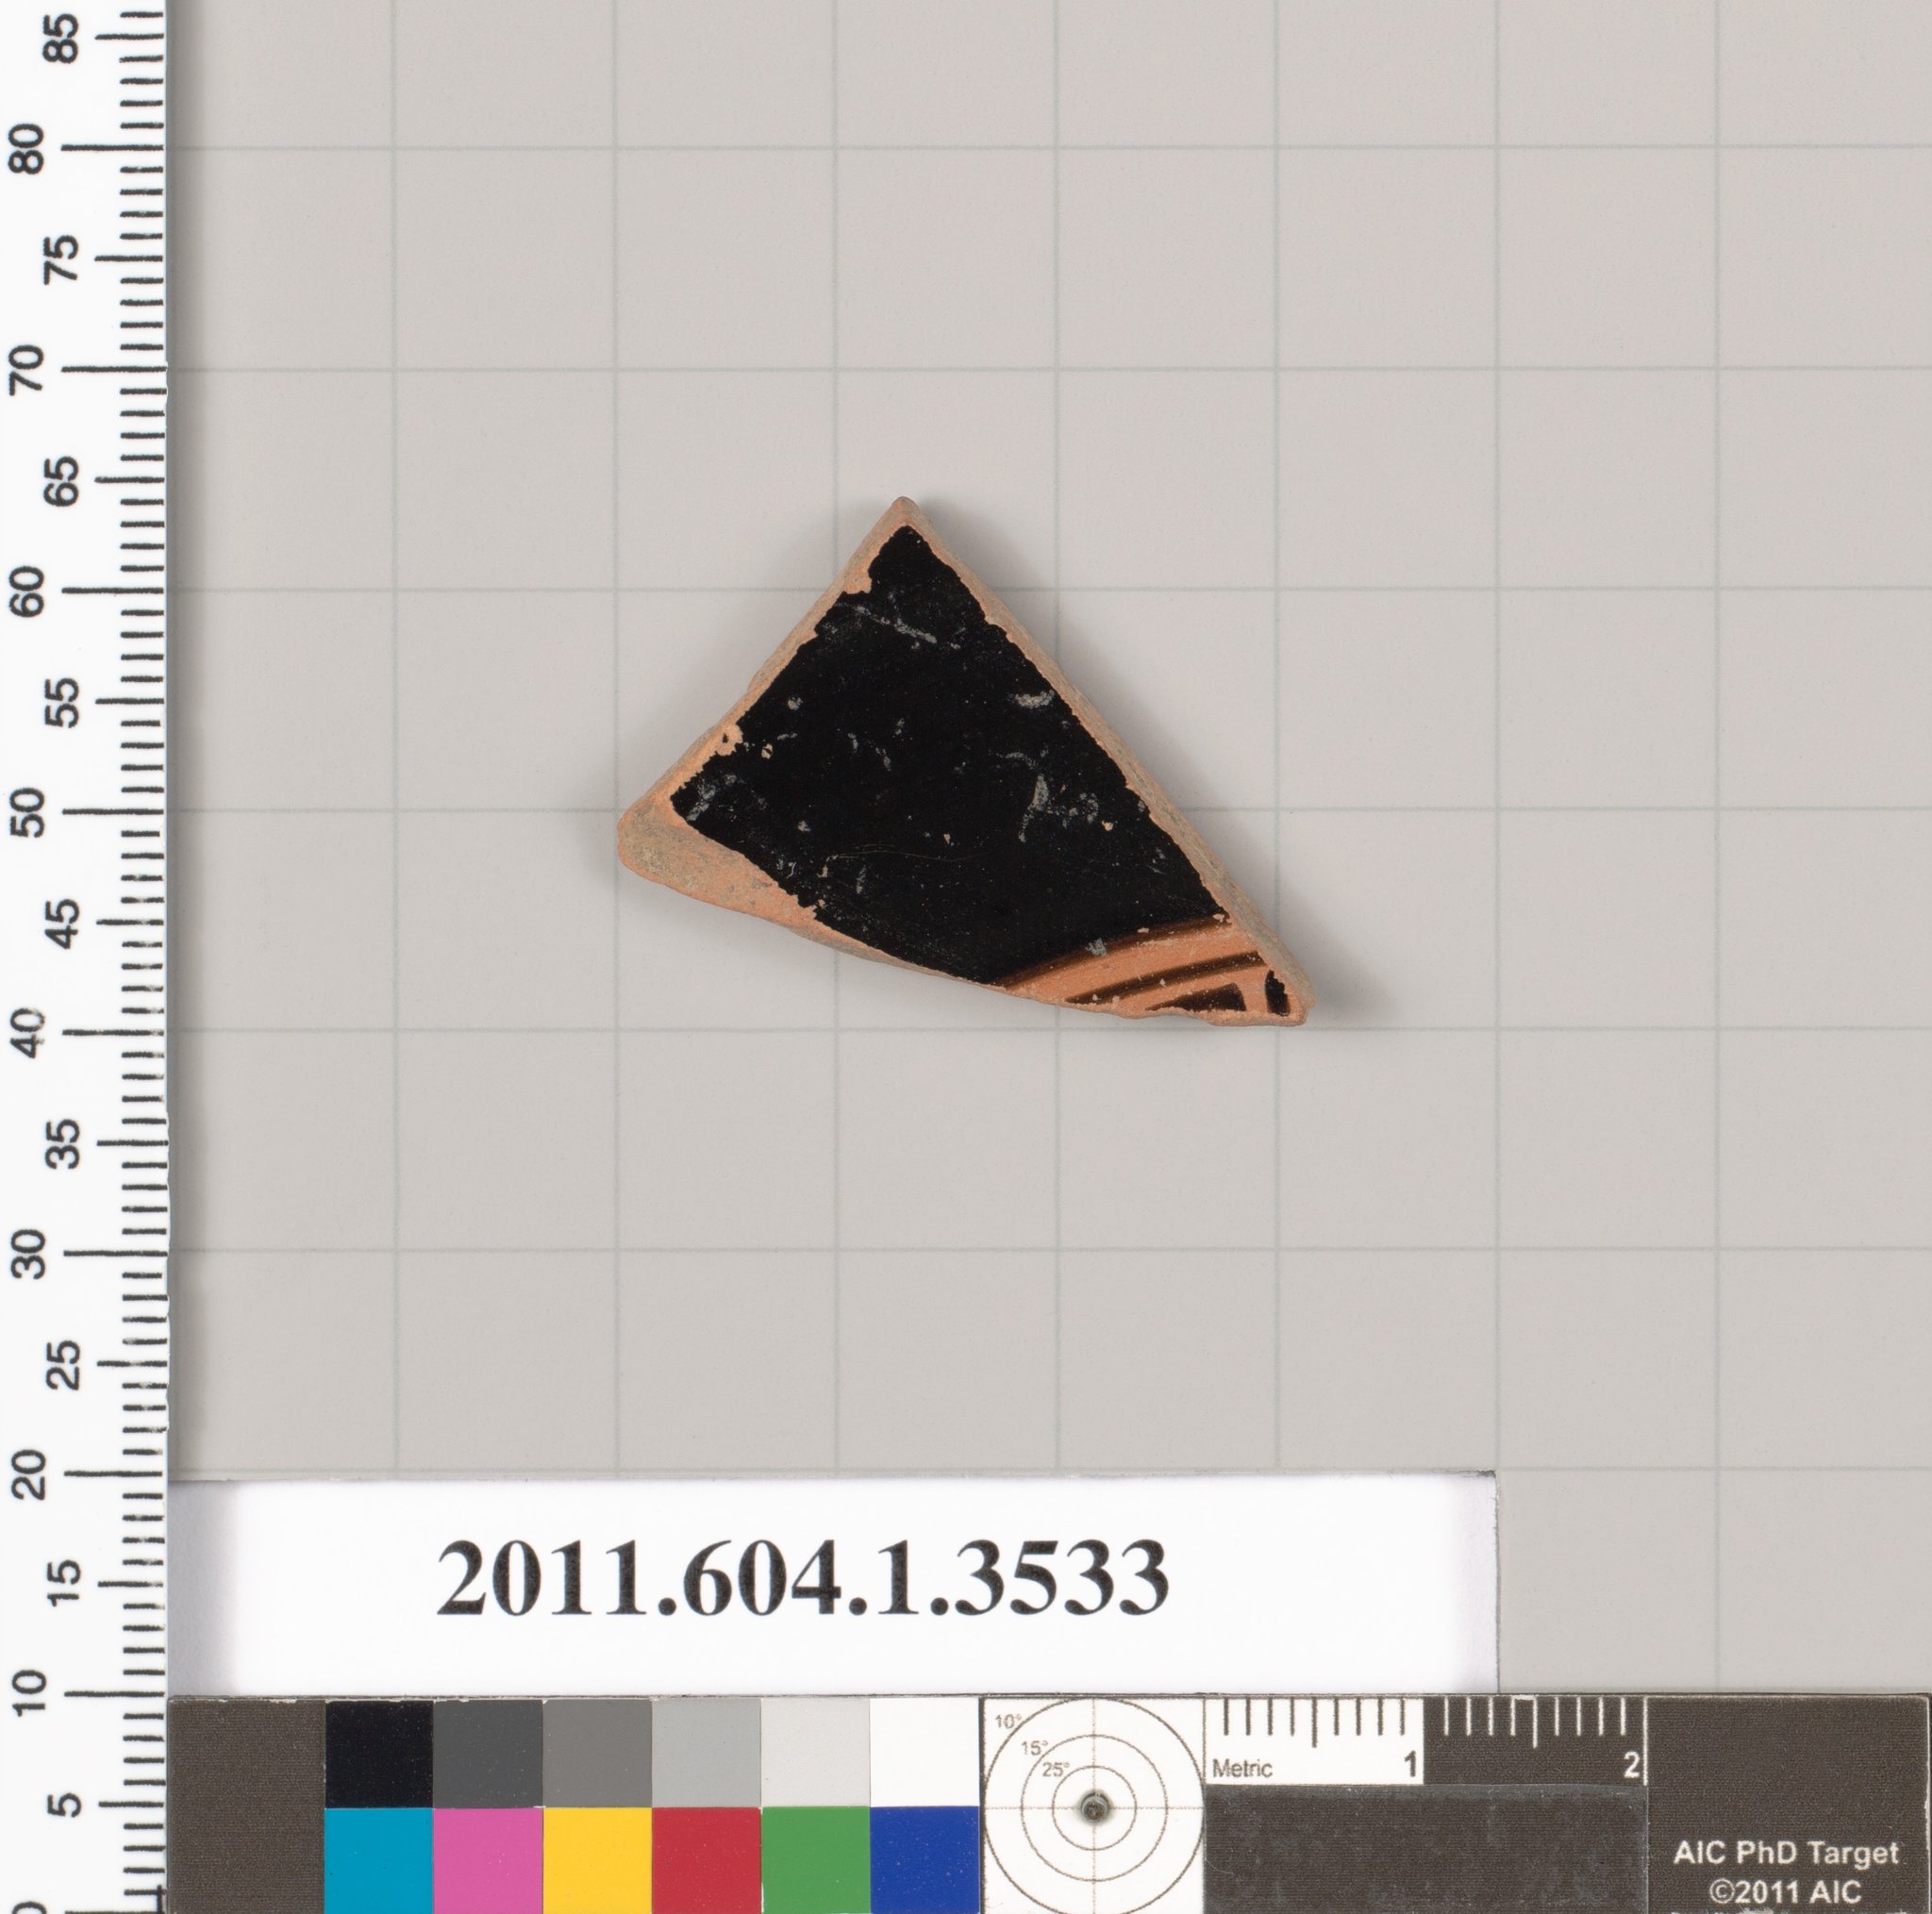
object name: kylix fragment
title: Terracotta fragment of a kylix (drinking cup)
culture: greek, attic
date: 475-451 BCE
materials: terracotta